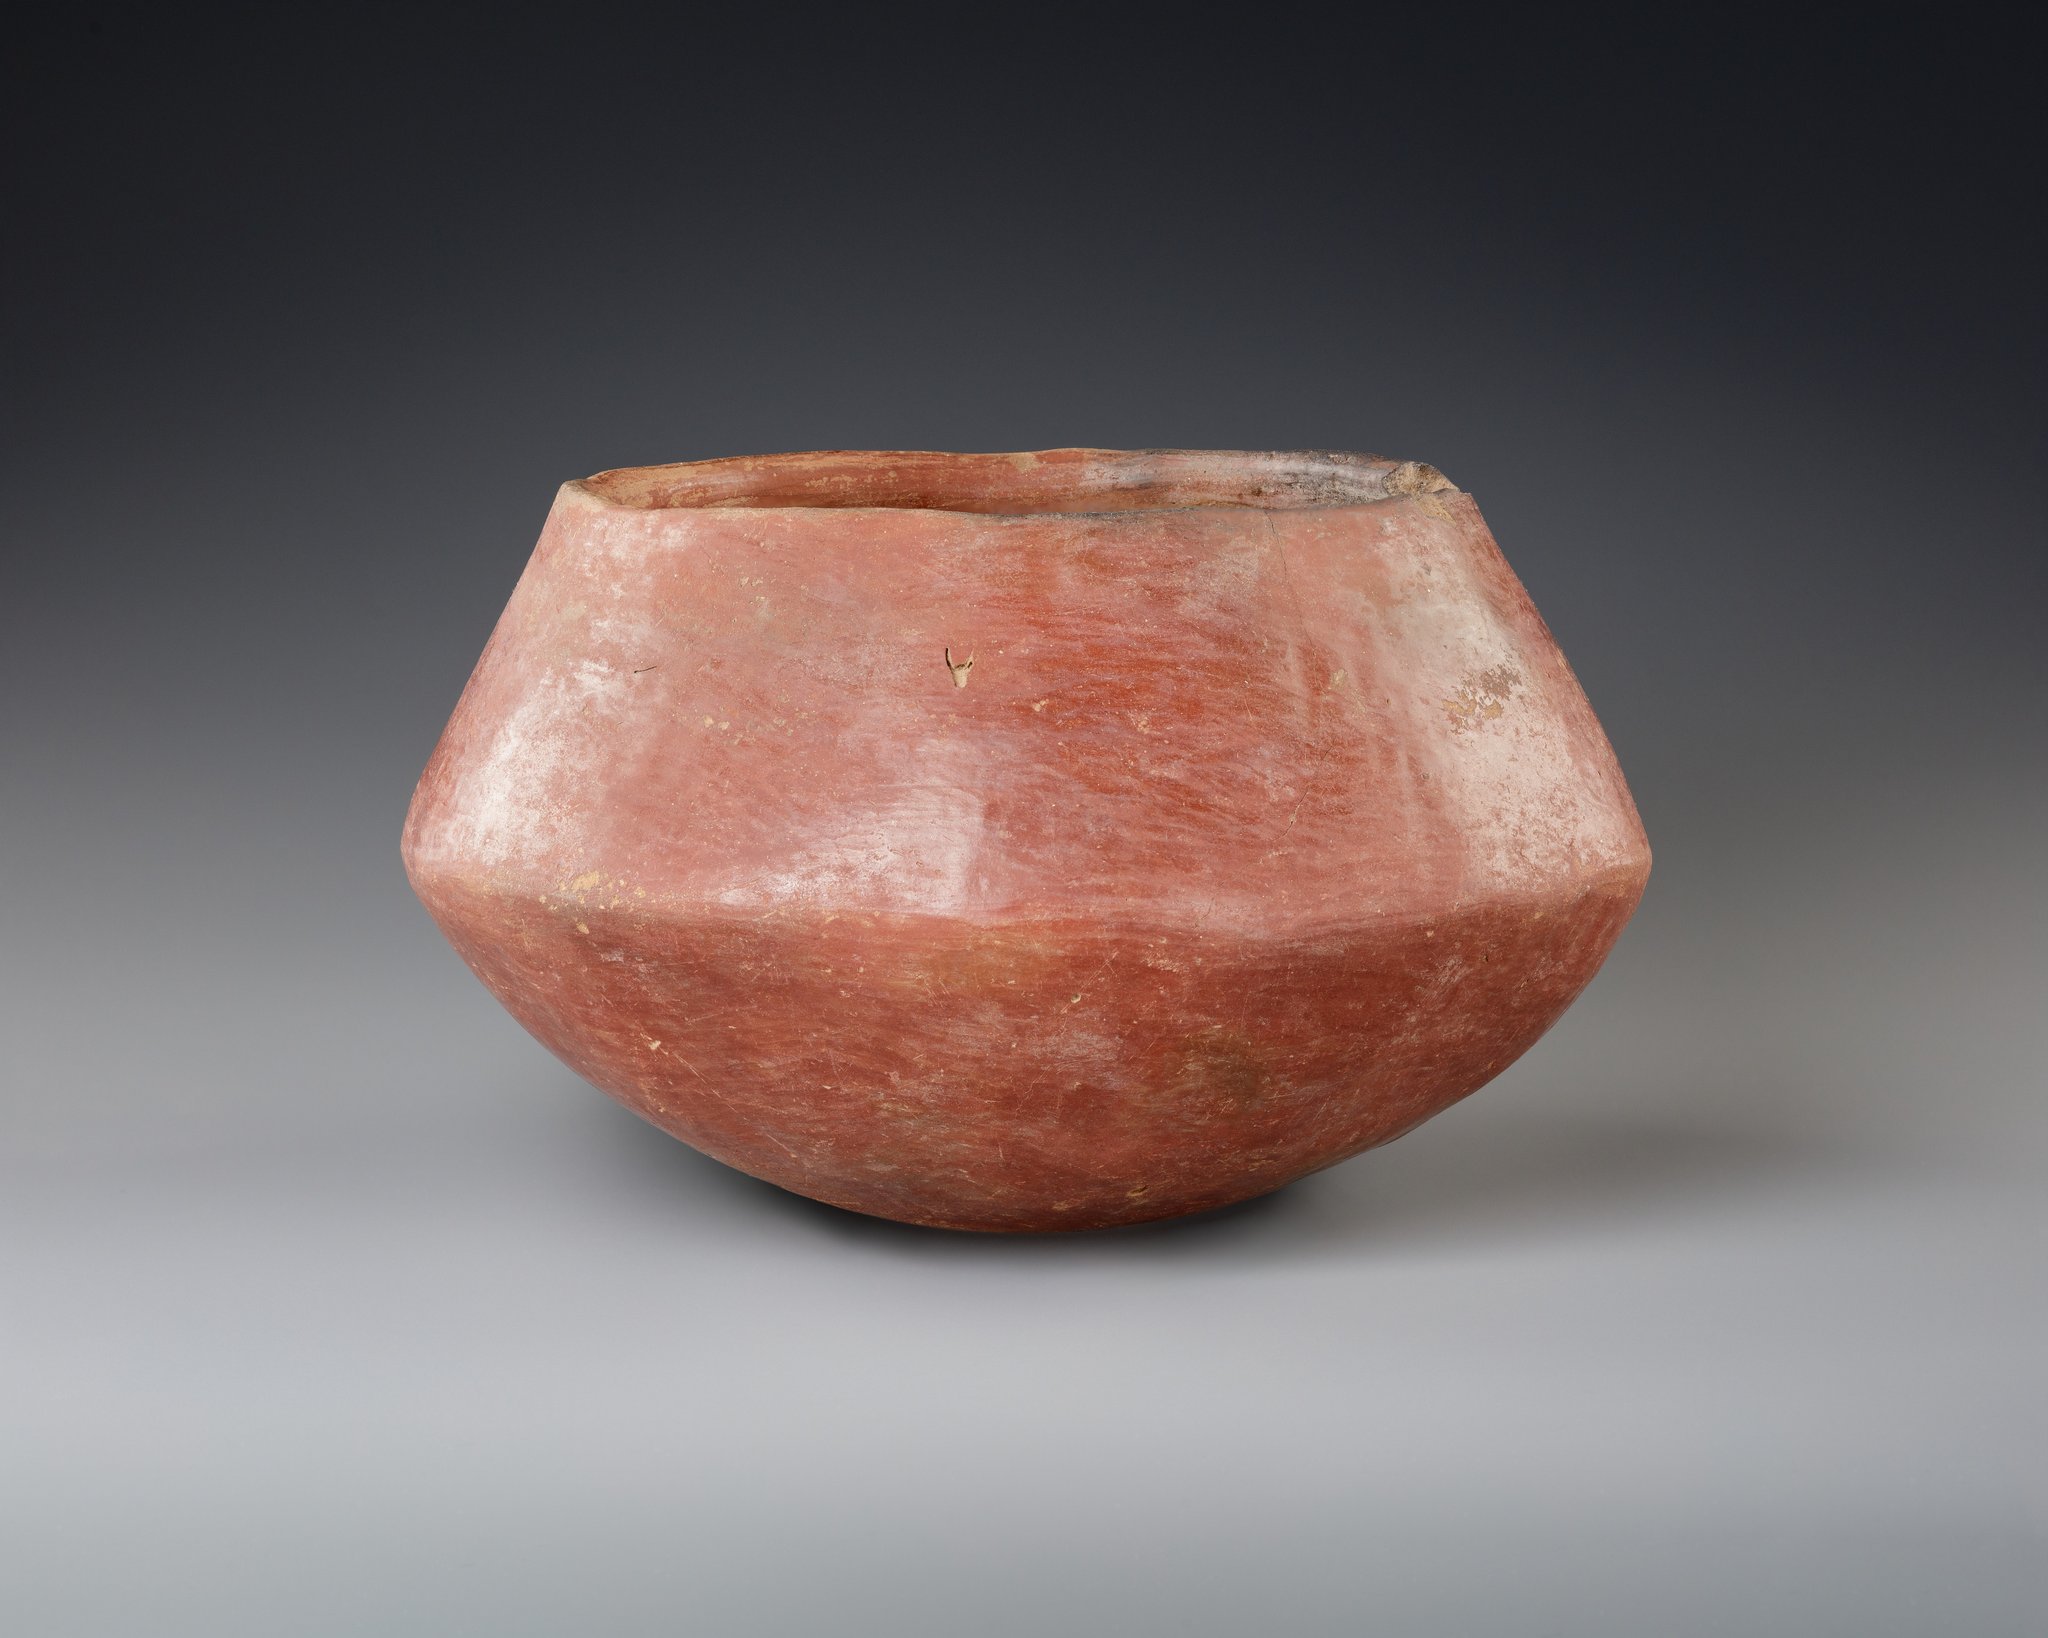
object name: bowl, red polished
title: Red polished ware bowl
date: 3900-3750 BCE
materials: pottery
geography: egypt